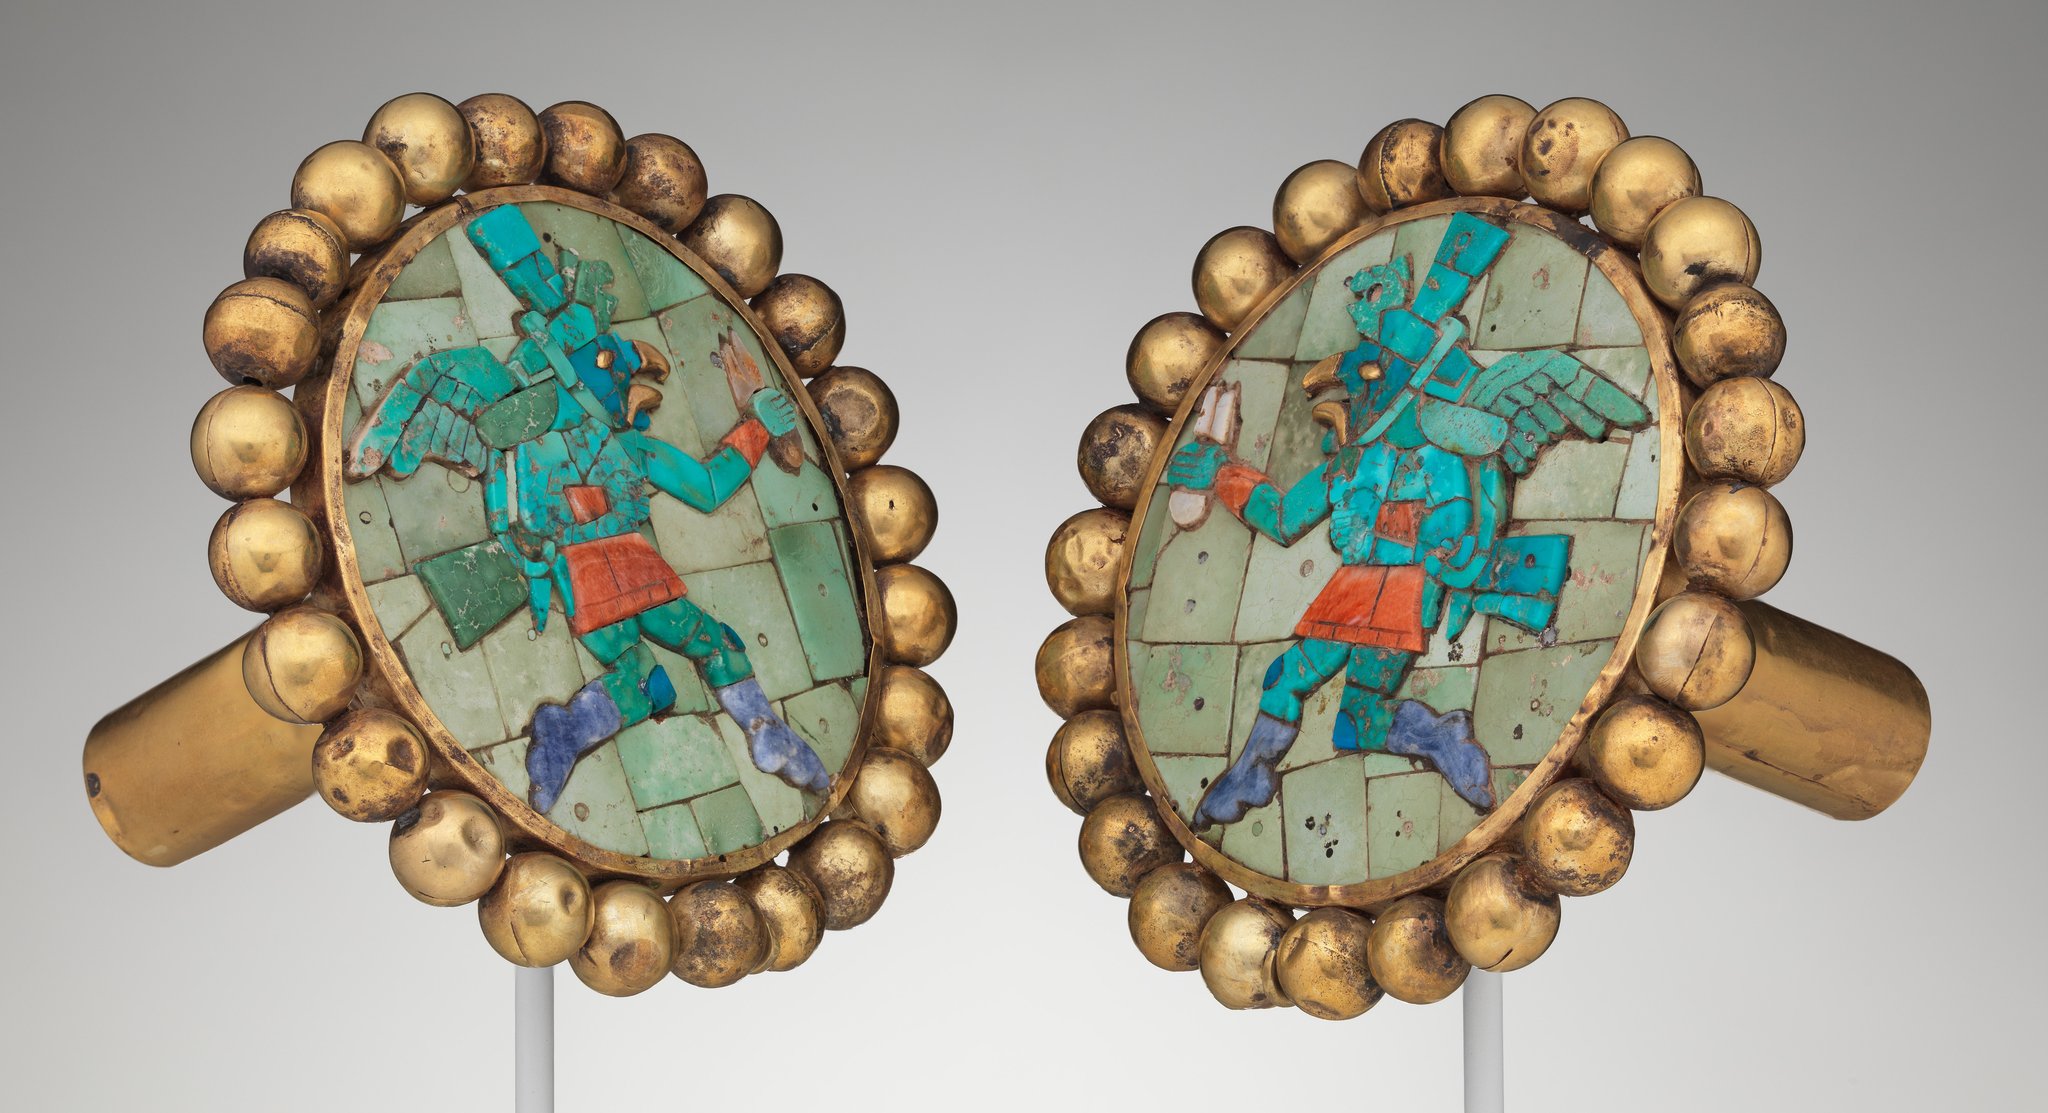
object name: earflare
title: Pair of Ear Ornaments with Winged Runners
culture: moche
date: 400-700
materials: gold, shell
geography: peru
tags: birds,running